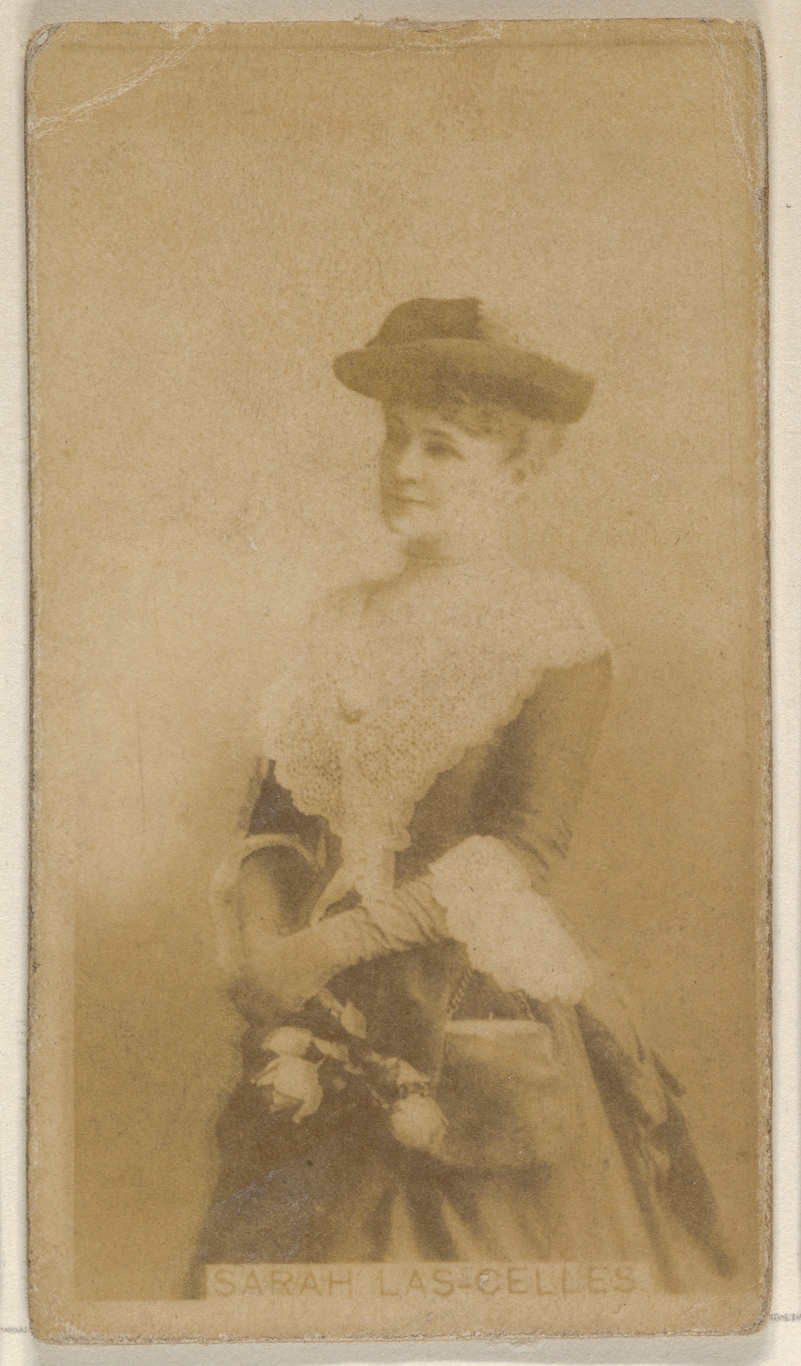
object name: photograph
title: Sarah Las Celles, from the Actors and Actresses series (N45, Type 8) for Virginia Brights Cigarettes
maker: allen & ginter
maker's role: publisher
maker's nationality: american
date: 1888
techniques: albumen silver print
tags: portraits,women,actresses